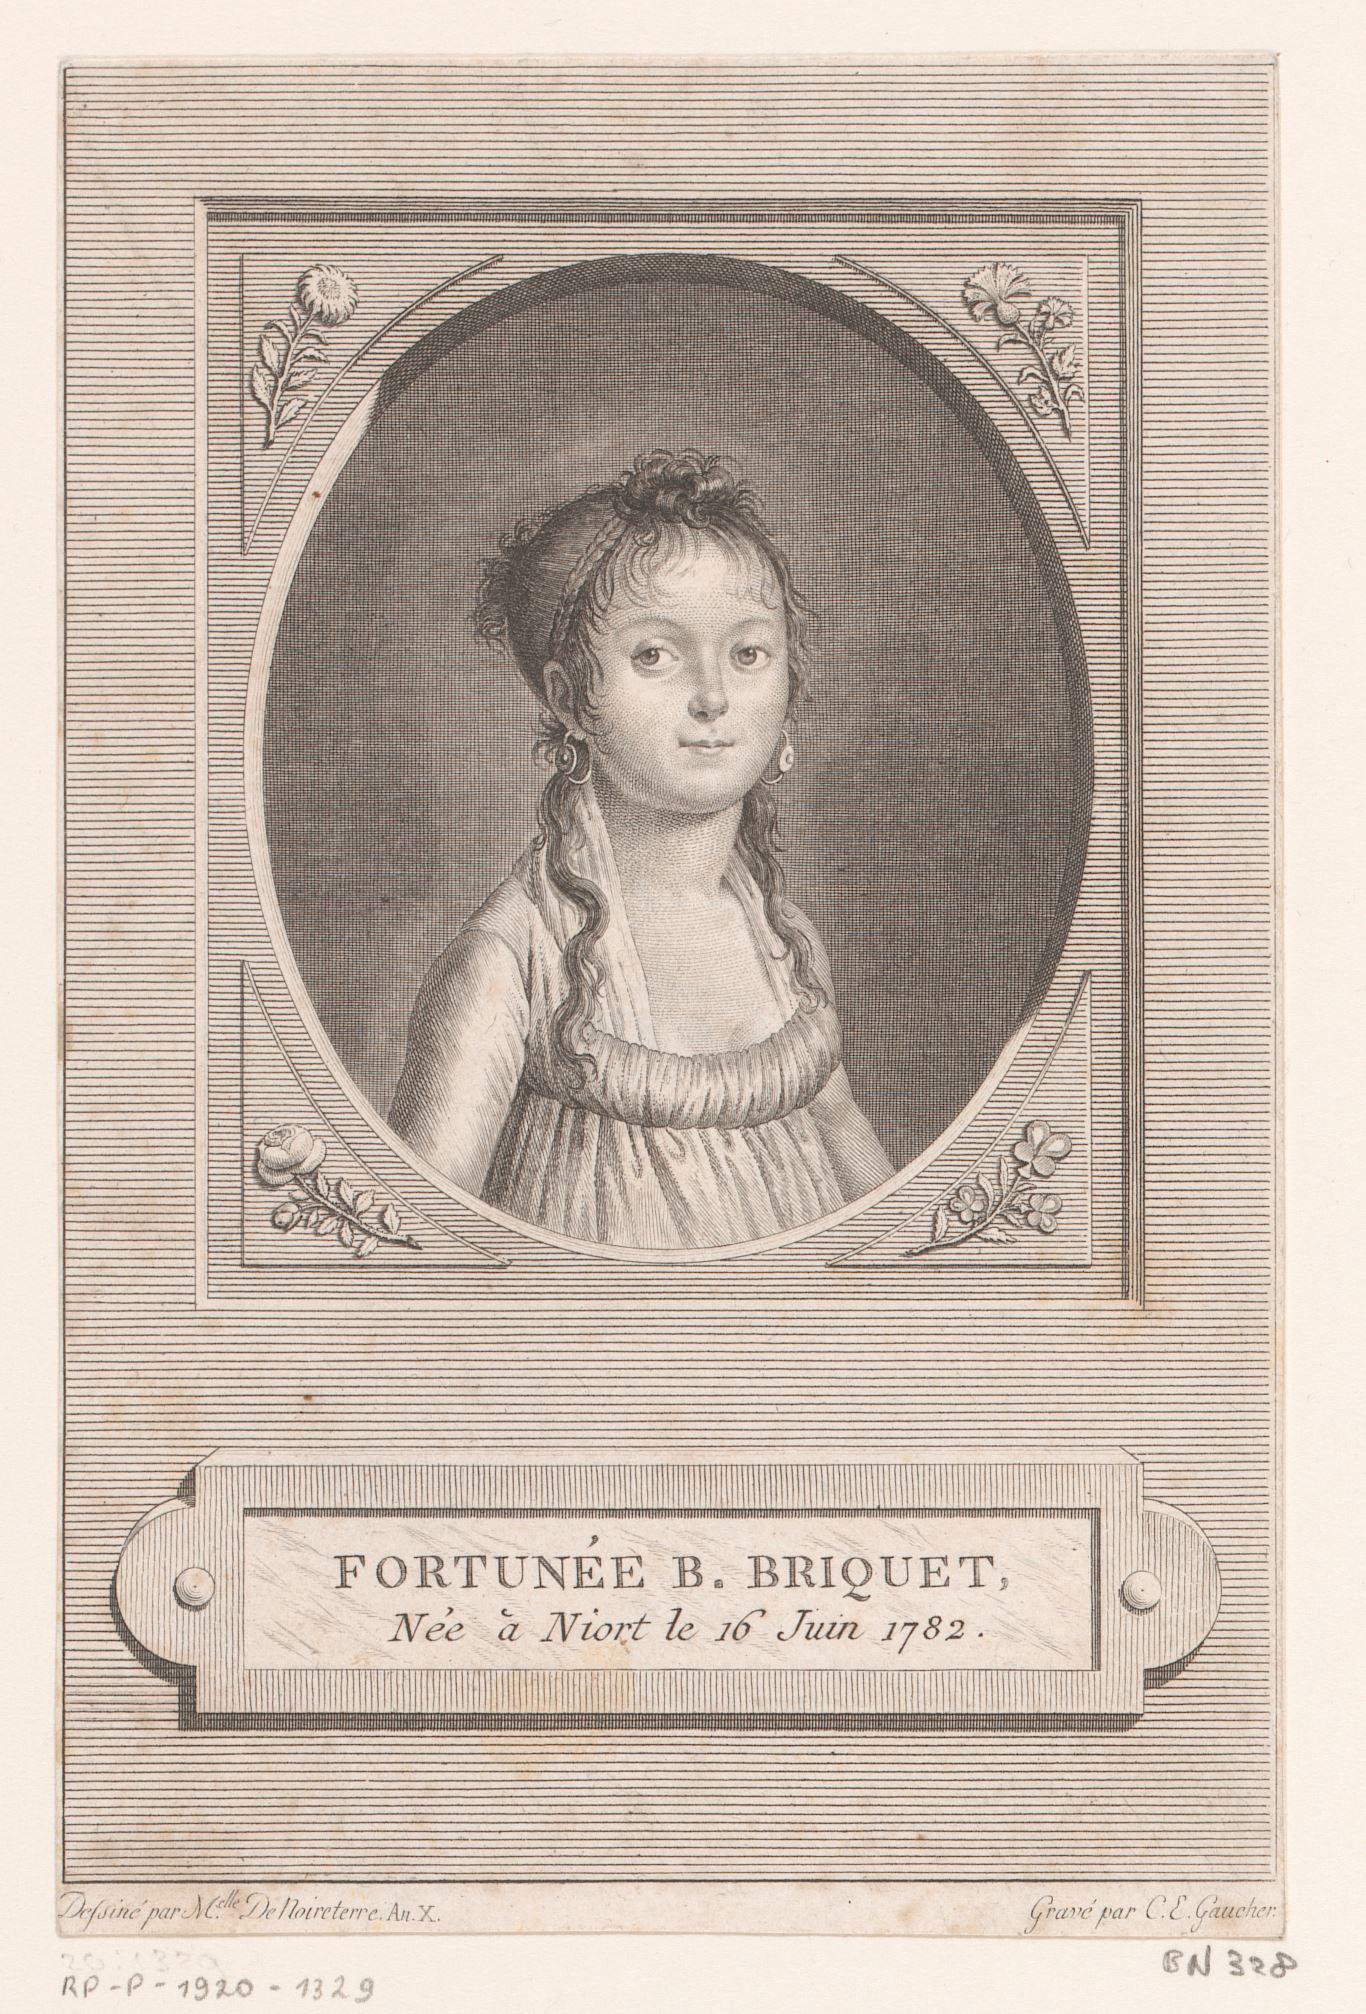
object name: print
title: Portret van Fortunée Briquet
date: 1804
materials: paper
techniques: engraving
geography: france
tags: ornament ~ medallion, historical persons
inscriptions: collector's mark: Lugt 2228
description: Prent uit: Briquet, Fortunée. Dictionnaire historique, littéraire et bibliographique des Françaises, et des étrangères naturalisées en France (...). Parijs: Treuttel & Würtz, 1804.